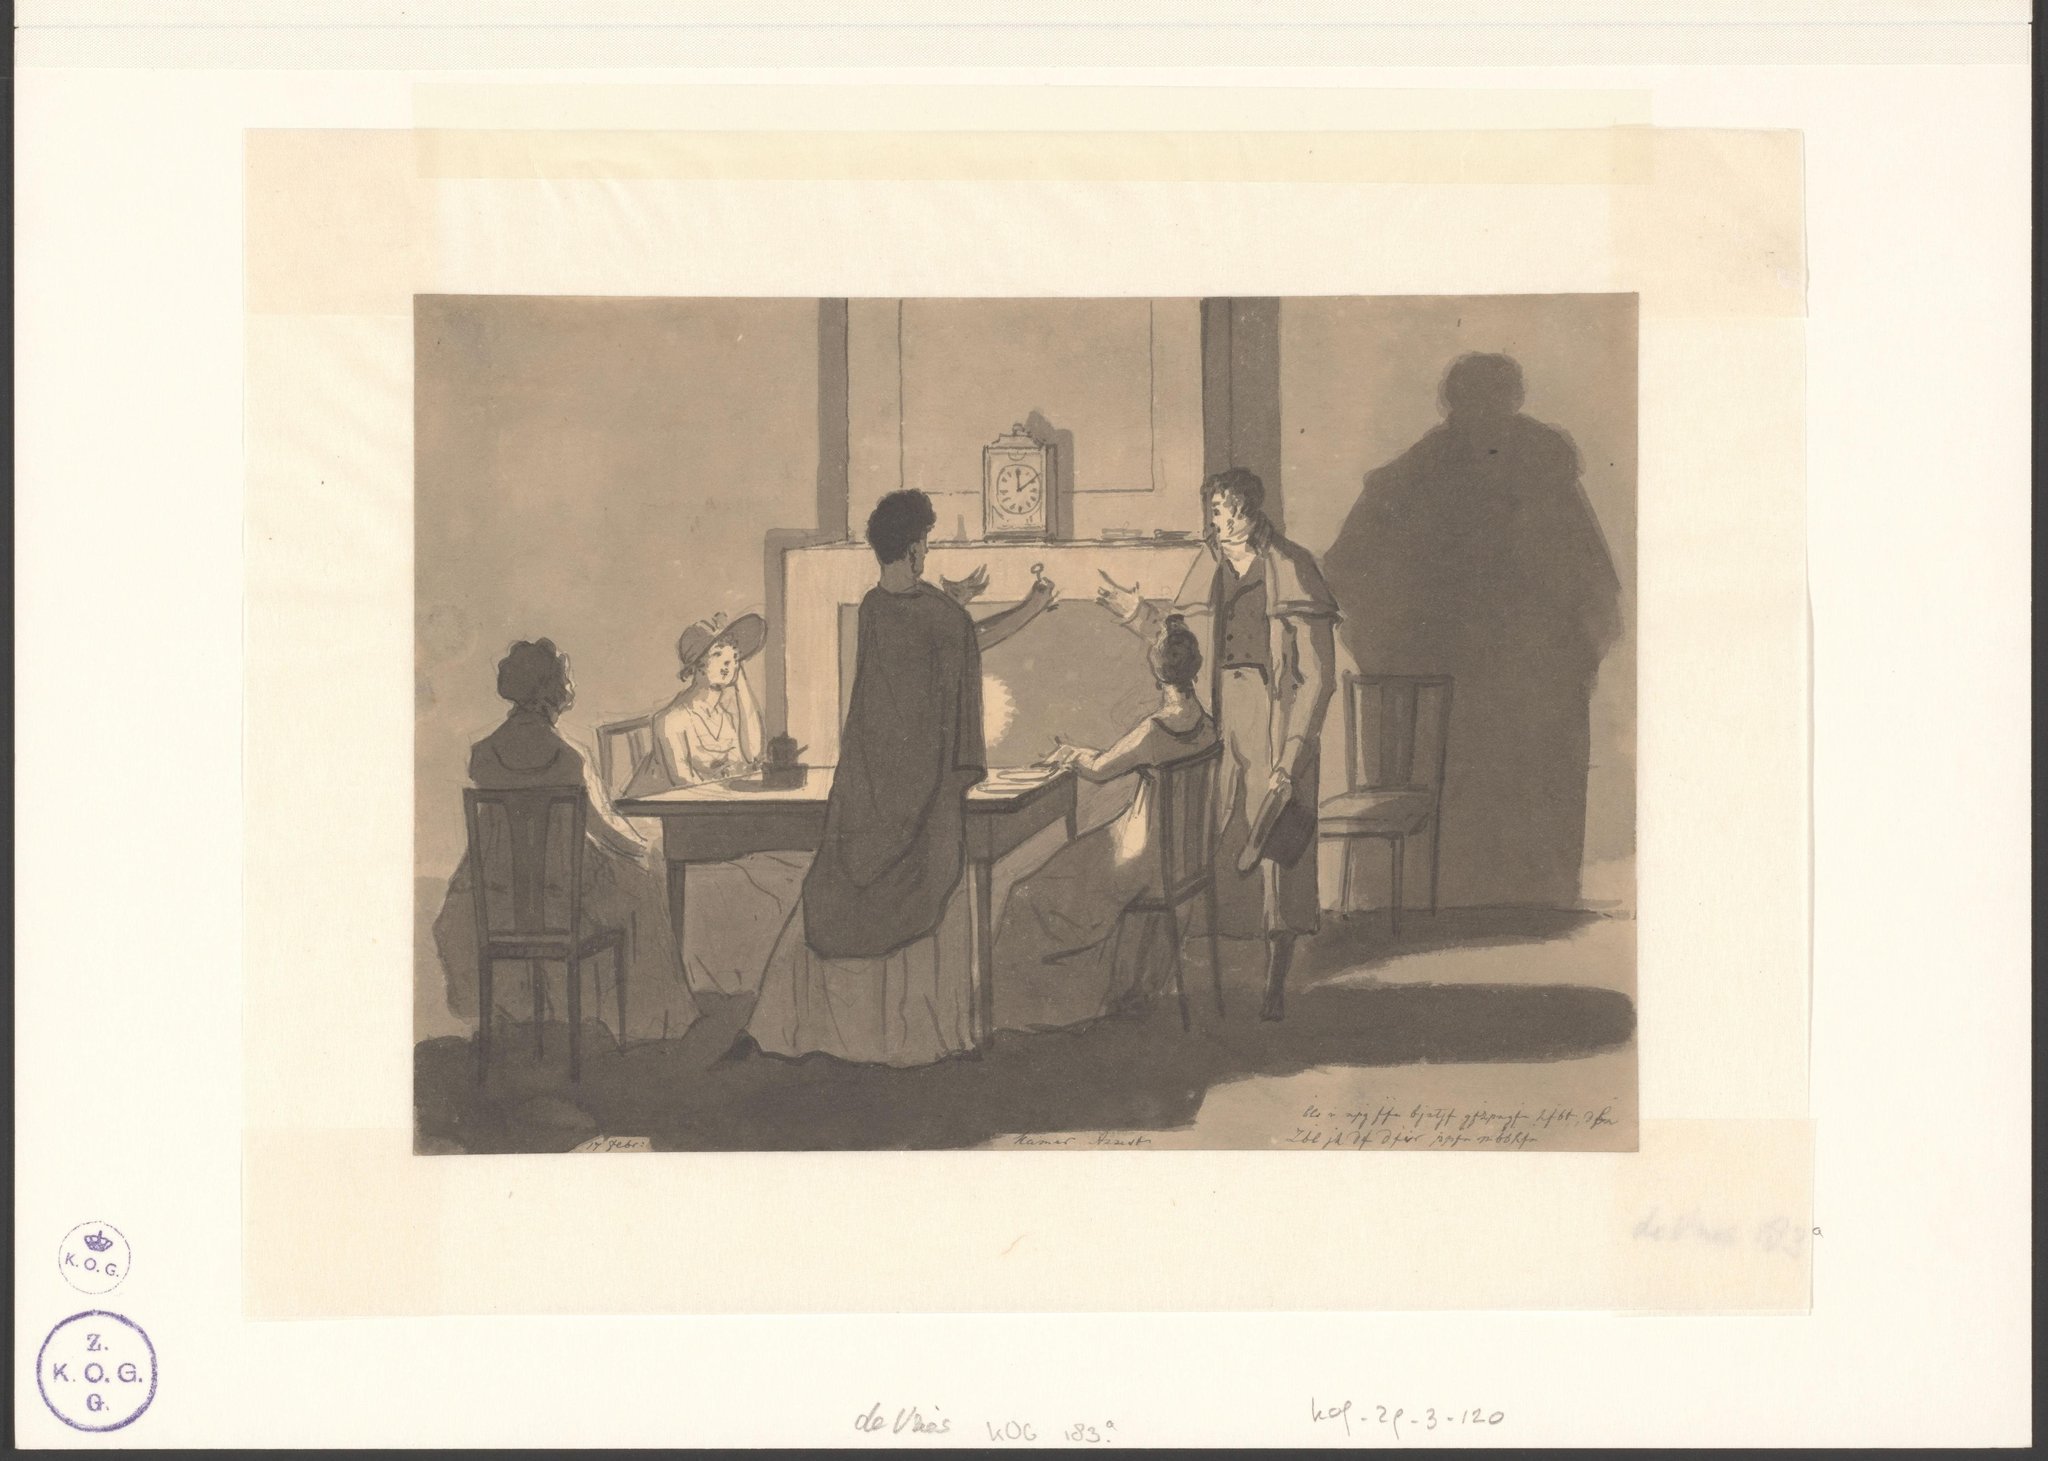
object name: print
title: Christiaan Andriessen mag niet naar huis na een tekenles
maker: christiaan andriessen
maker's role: draughtsman, print maker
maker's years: 1775-1846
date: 1806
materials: ink, paper, pencil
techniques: brush, pen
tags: amsterdam, print maker, draughtsman, christiaan andriessen, adult woman, evening, table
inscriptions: collector's mark: Lugt 1641a, inscription:, inscription: ‘17 febr: Kamer Arrest’, signature:, collector's mark: Lugt 1641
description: Christiaan Andriessen wordt vastgehouden door vier vrouwelijke leerlingen, die hem dwingen nog een liedje te zingen. Willemina Balk, die blijkbaar het voortouw heeft genomen, heeft de sleutel van de kamerdeur die op slot zit.